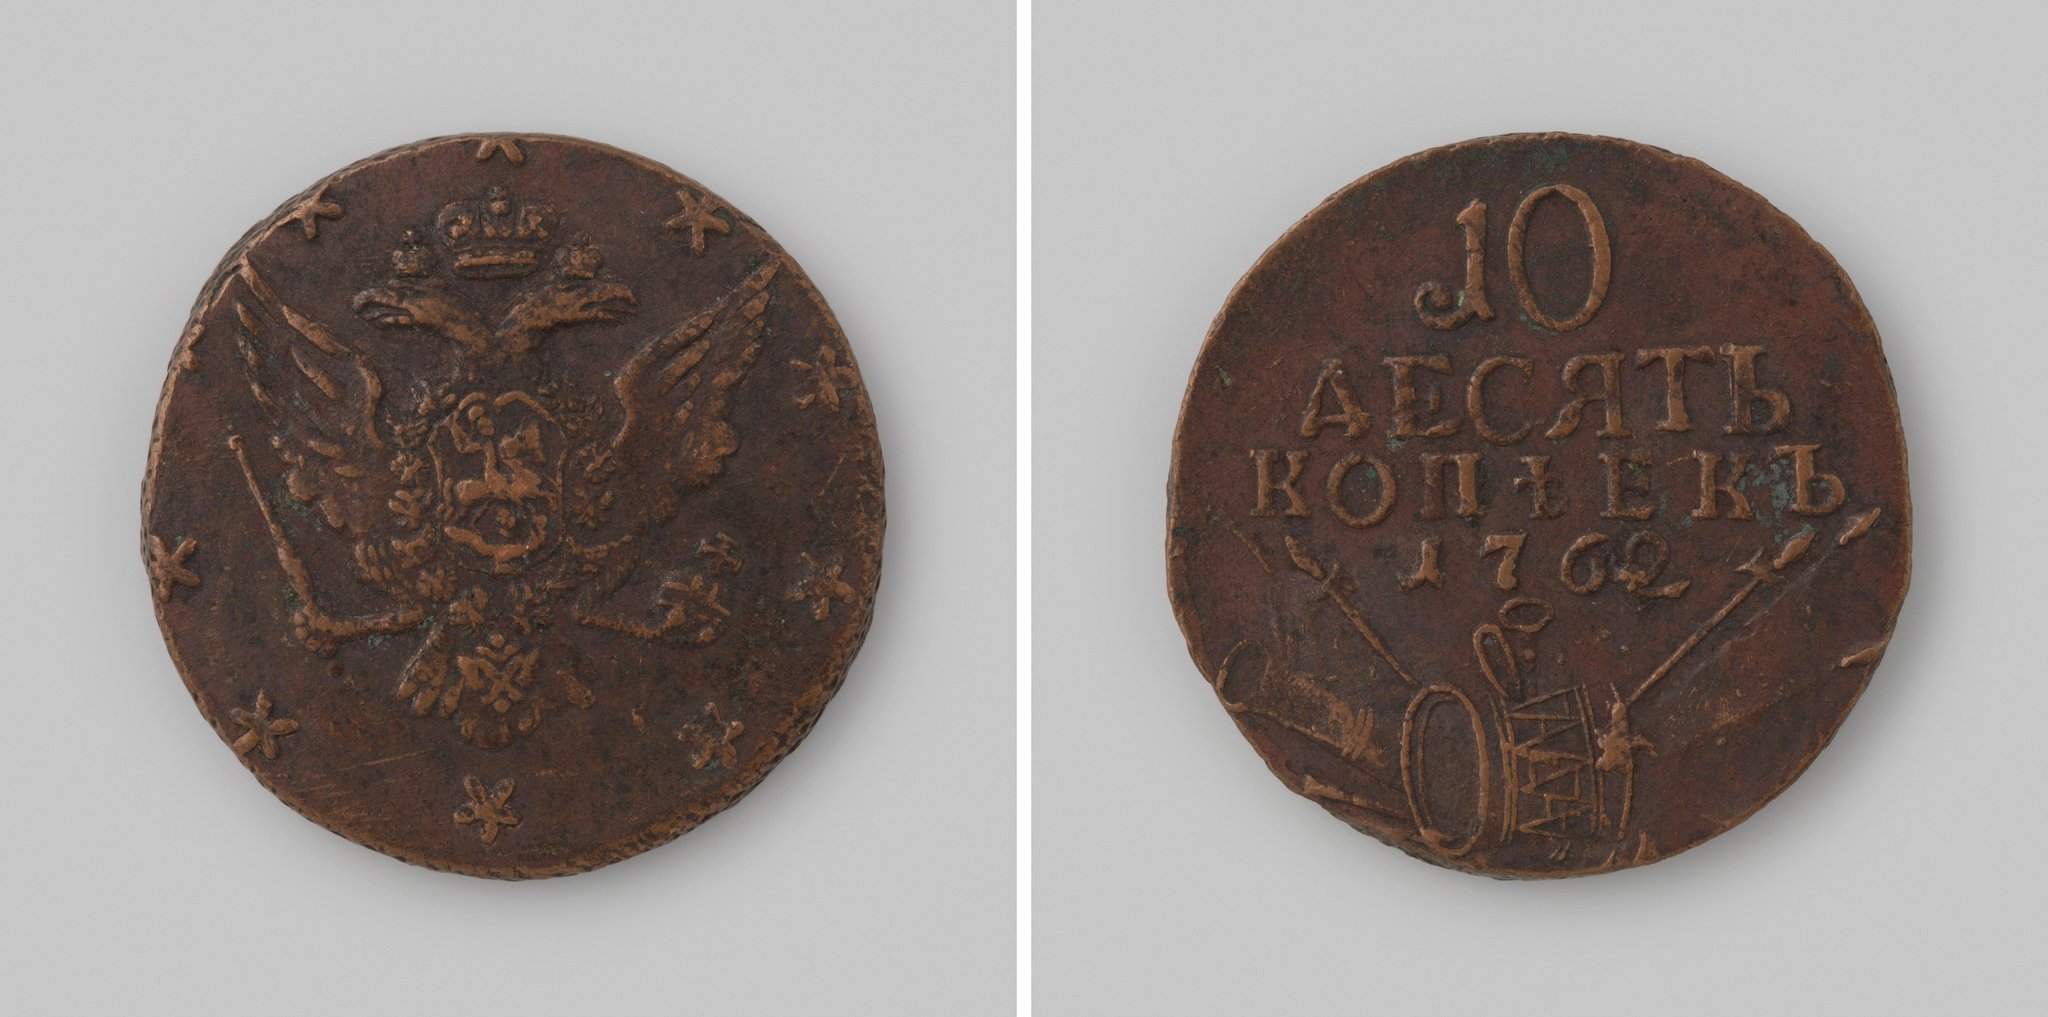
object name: coin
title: Rusland, tsaar Peter III, 10 kopeken,1762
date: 1762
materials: copper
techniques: striking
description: Koperen munt. Voorzijde: dubbelkoppige gekroonde adelaar met gespreide vleugels, met op zijn borst door ridderorde omhangen wapenschild en met in zijn poten scepter en bol met daarop kruis. Boven de adelaar een kroon. Rondom de adelaar 10 sterren als waarde-aanduiding.Keerzijde: boven een verzameling van leger-attributen waarde-aanduiding in twee regels, waaronder jaartal. Kabelrand.